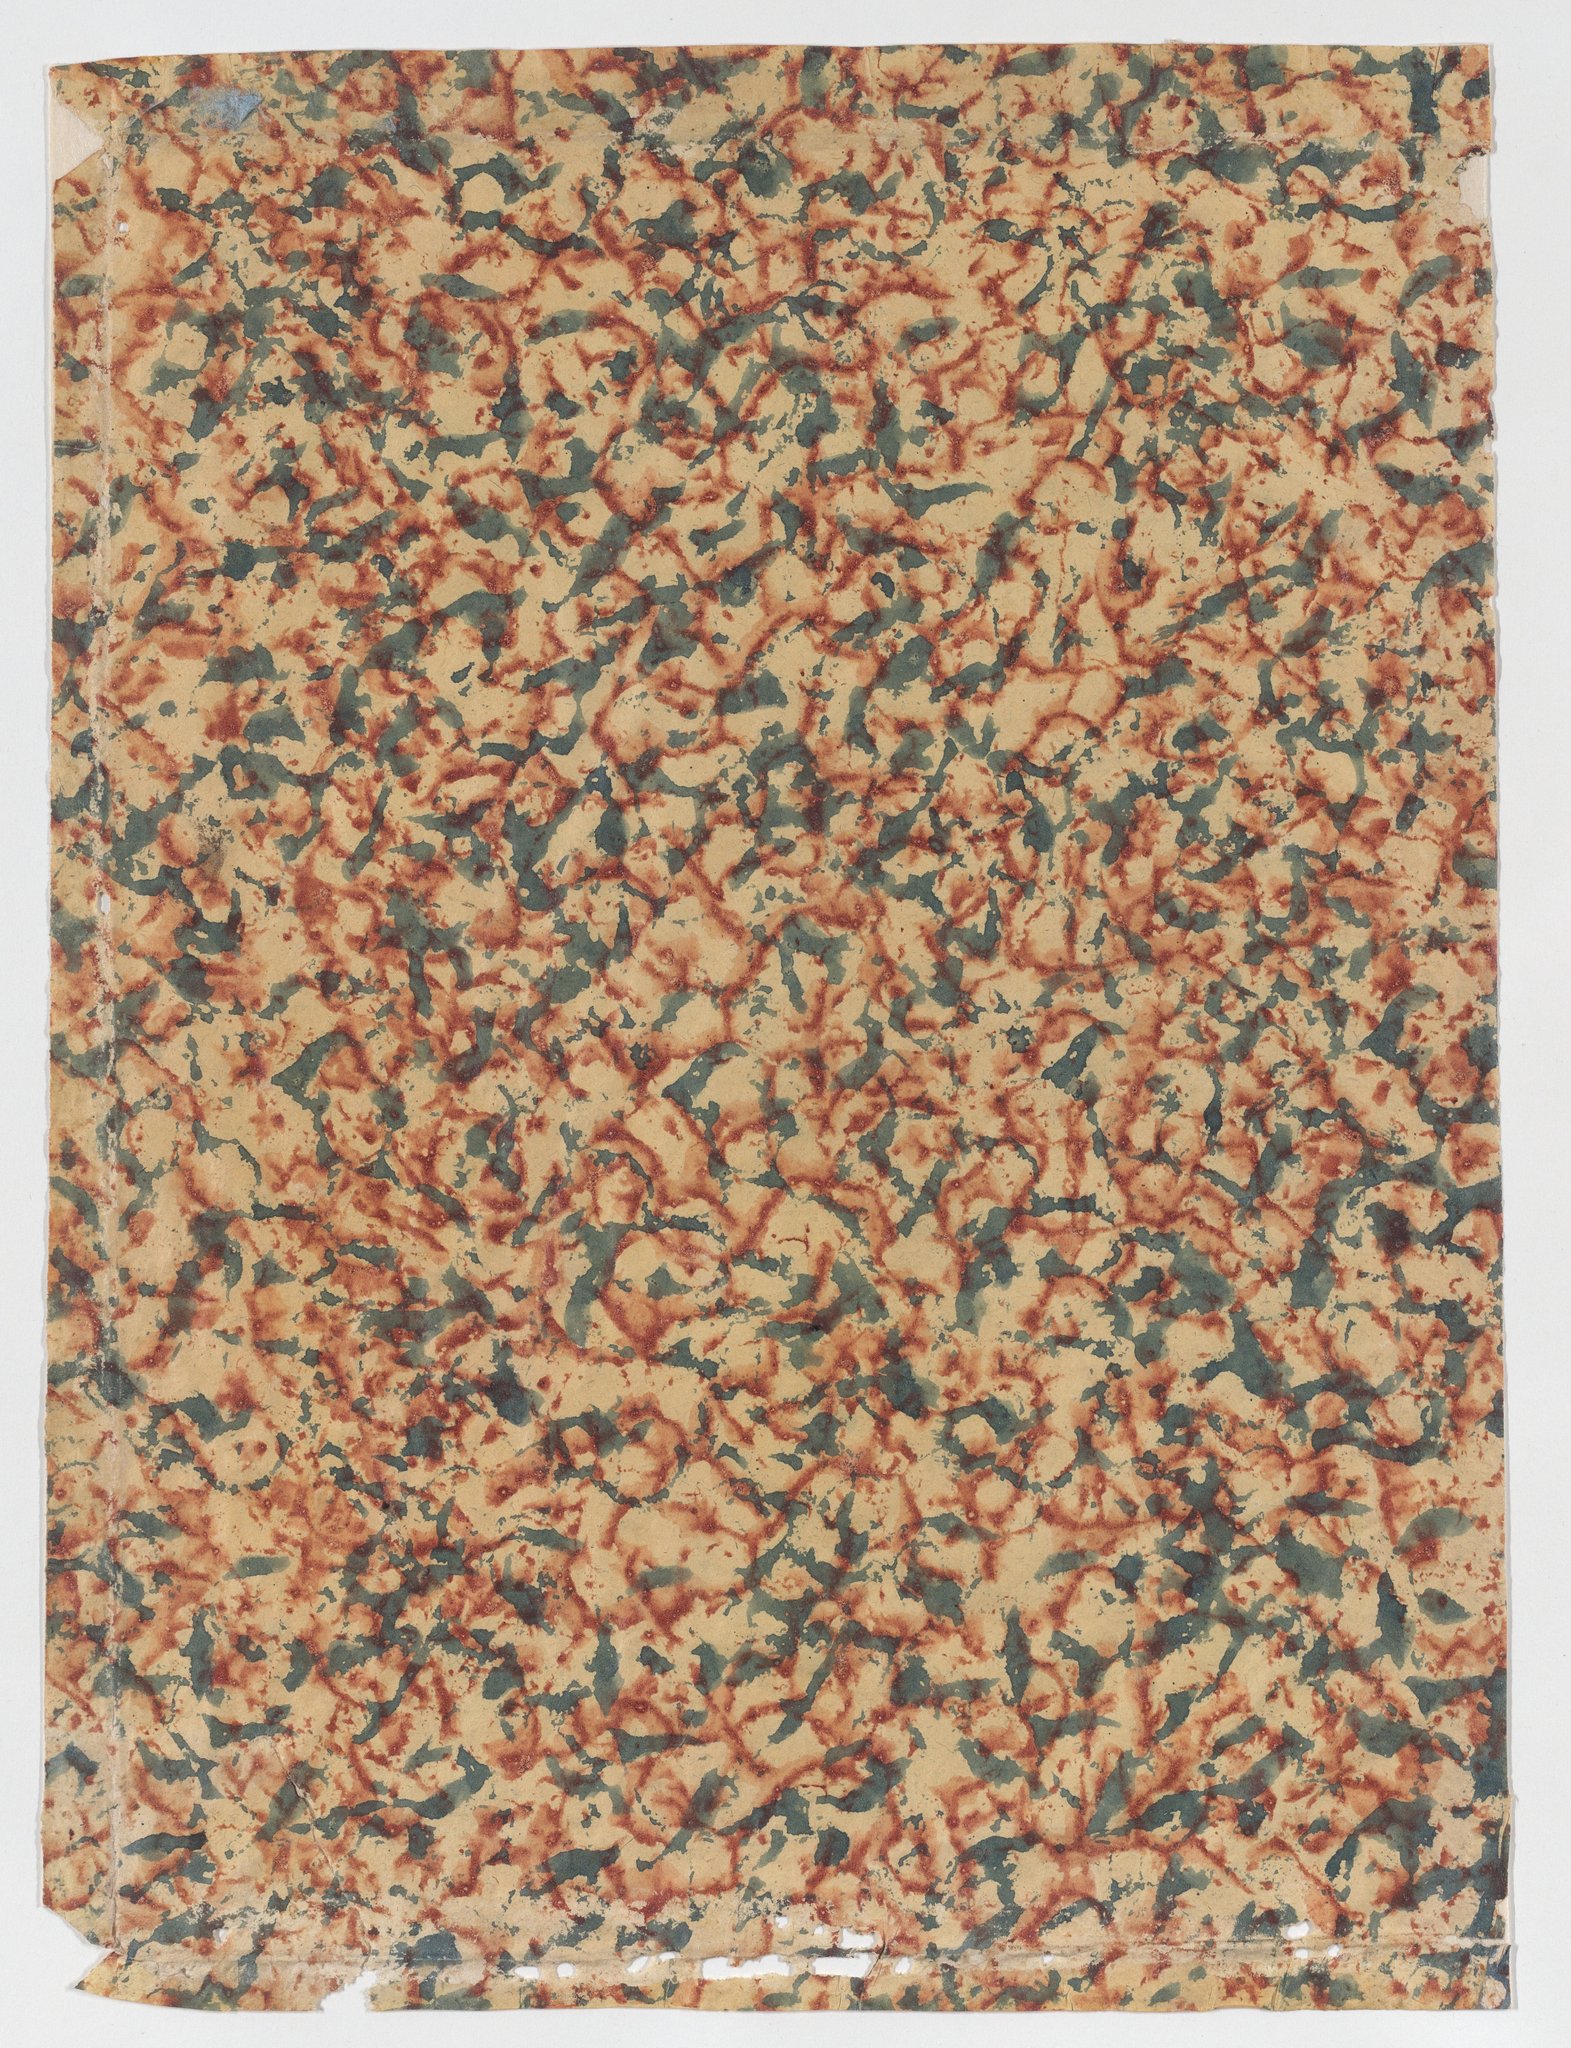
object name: print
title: Sheet with overall splotchy pattern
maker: Anonymous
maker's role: artist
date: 1801-1900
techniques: relief print